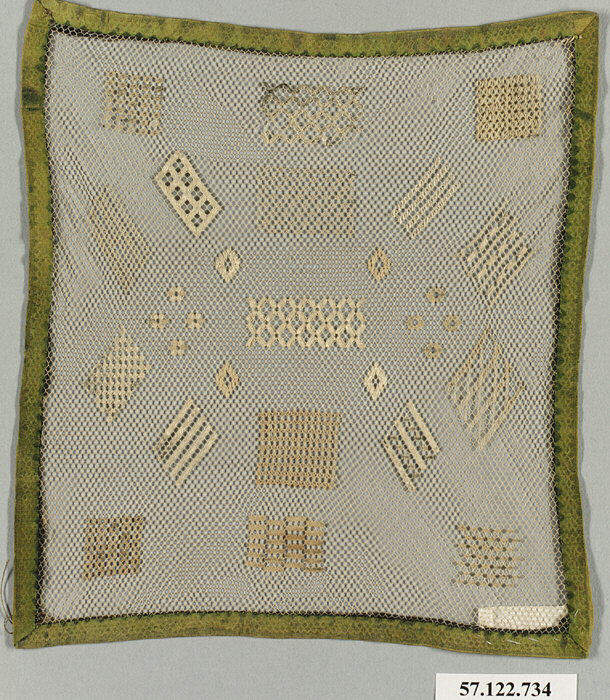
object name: sampler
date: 1801-1900